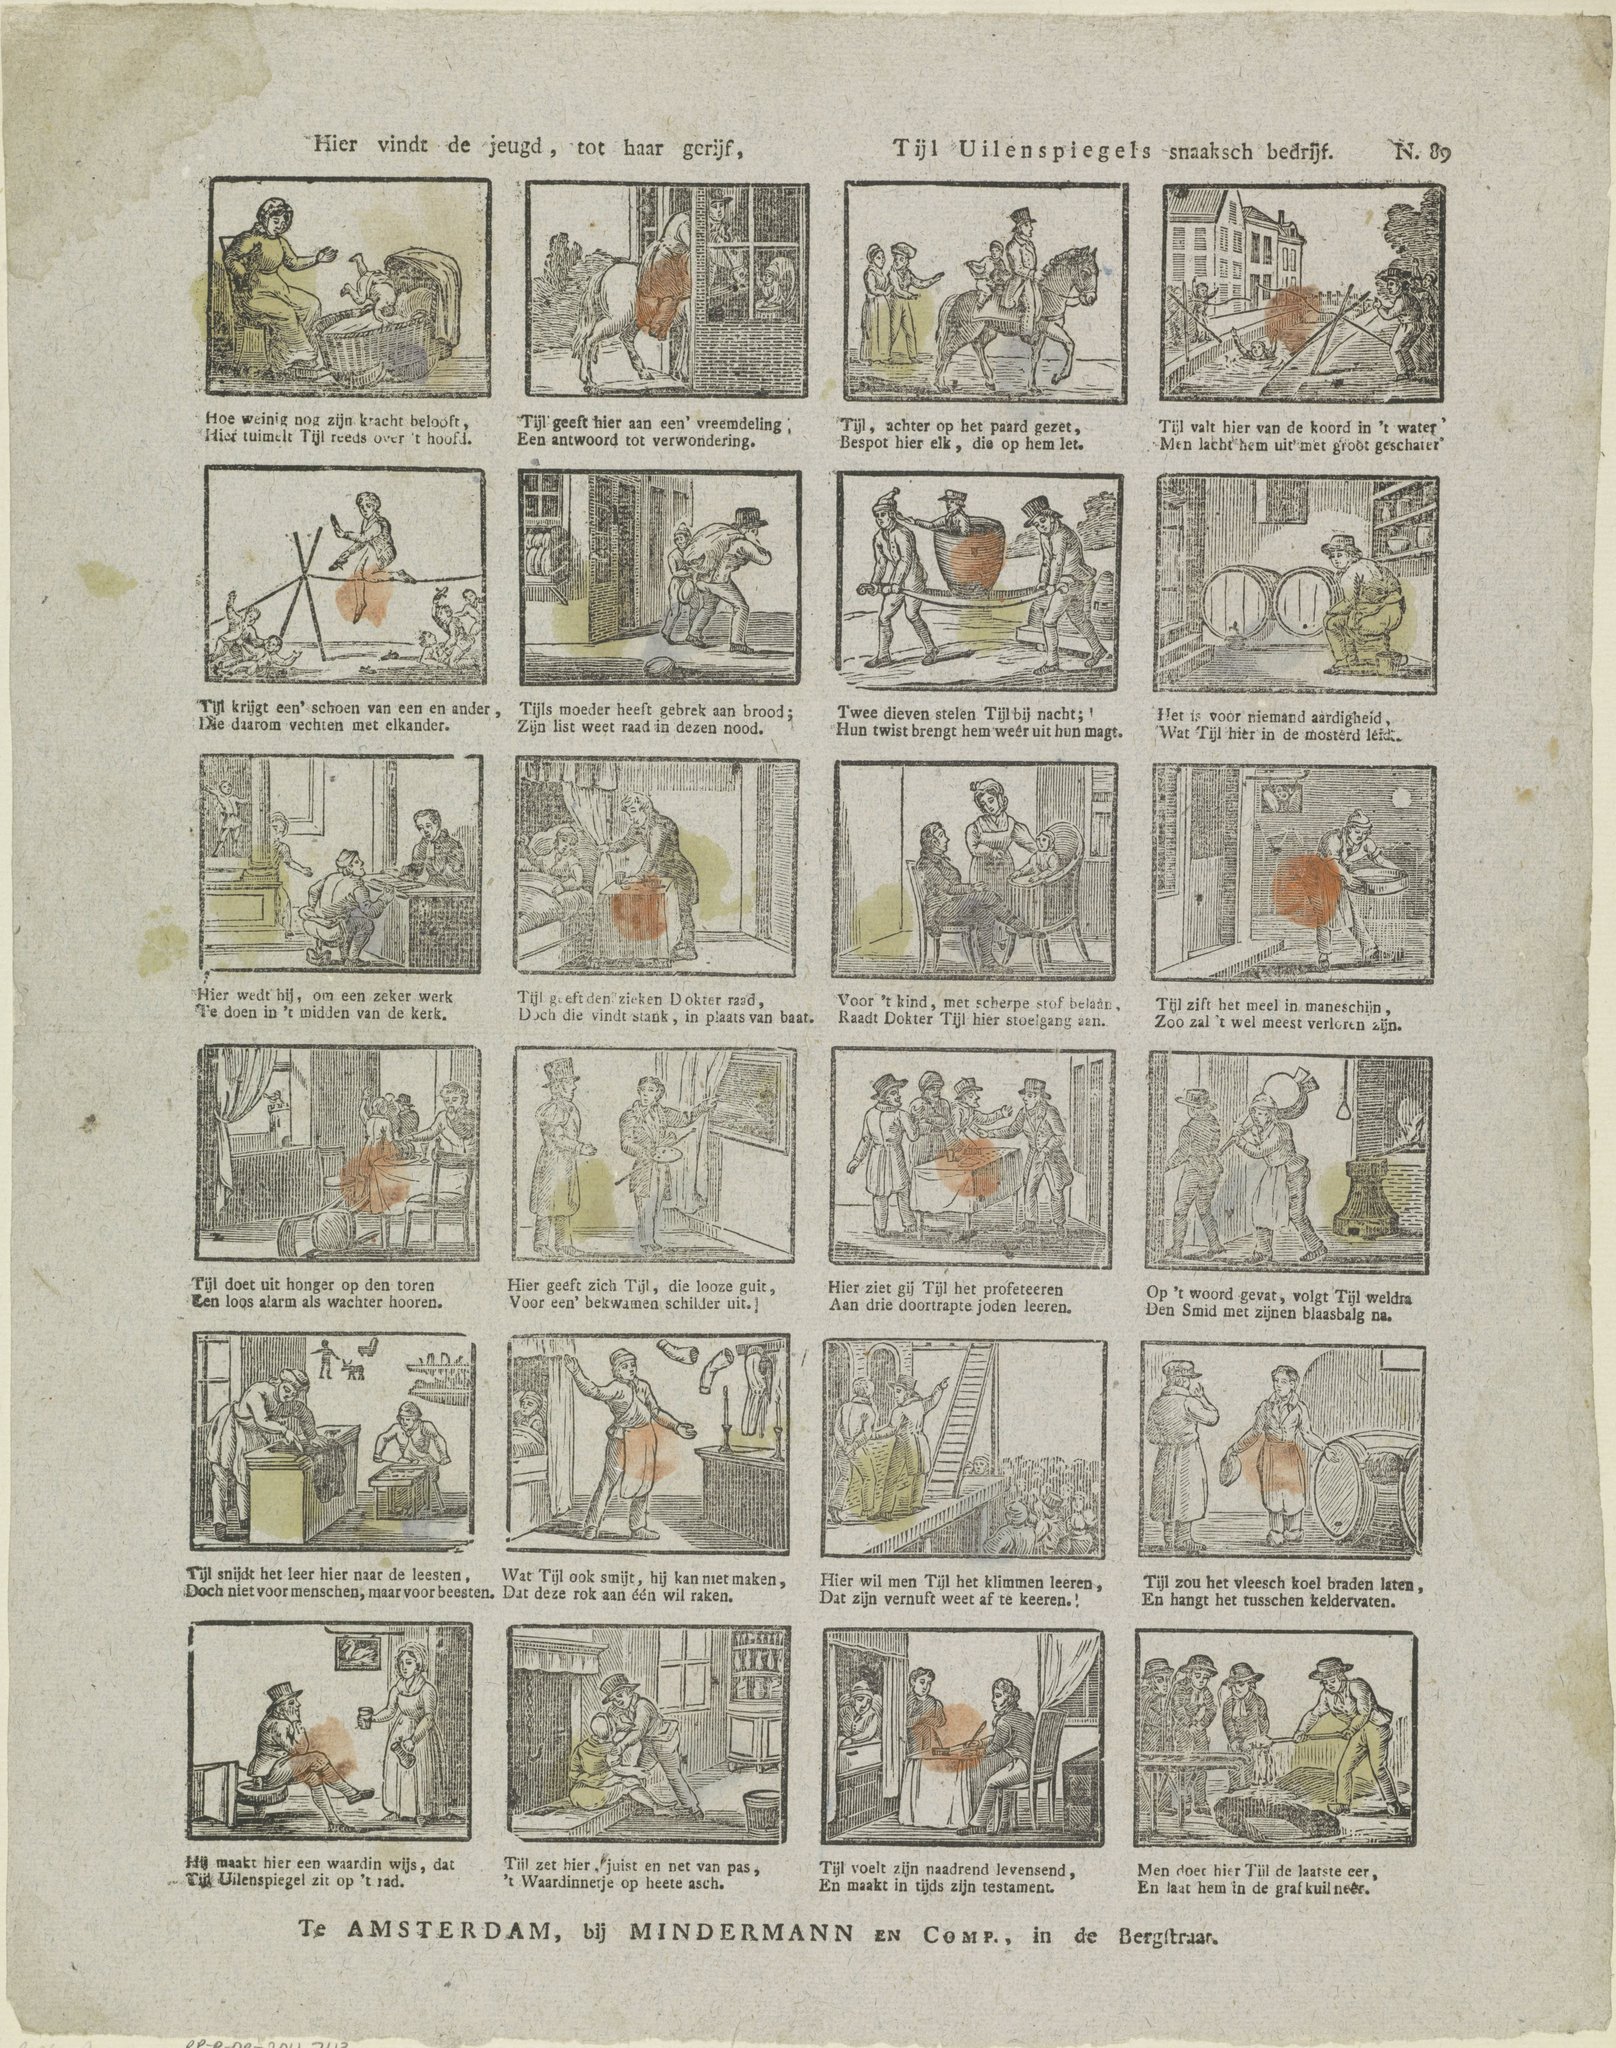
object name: print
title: Hier vindt de jeugd, tot haar gerijf, / Tijl Uilenspiegels snaaksch bedrijf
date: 1822-1849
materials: paper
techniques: colour, letterpress printing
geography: deventer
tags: eulenspiegel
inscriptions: collector's mark: Lugt 2760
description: Blad met 24 voorstellingen over het leven van Tijl Uilenspiegel. Onder elke afbeelding een tweeregelig vers. Genummerd rechtsboven: N. 89.